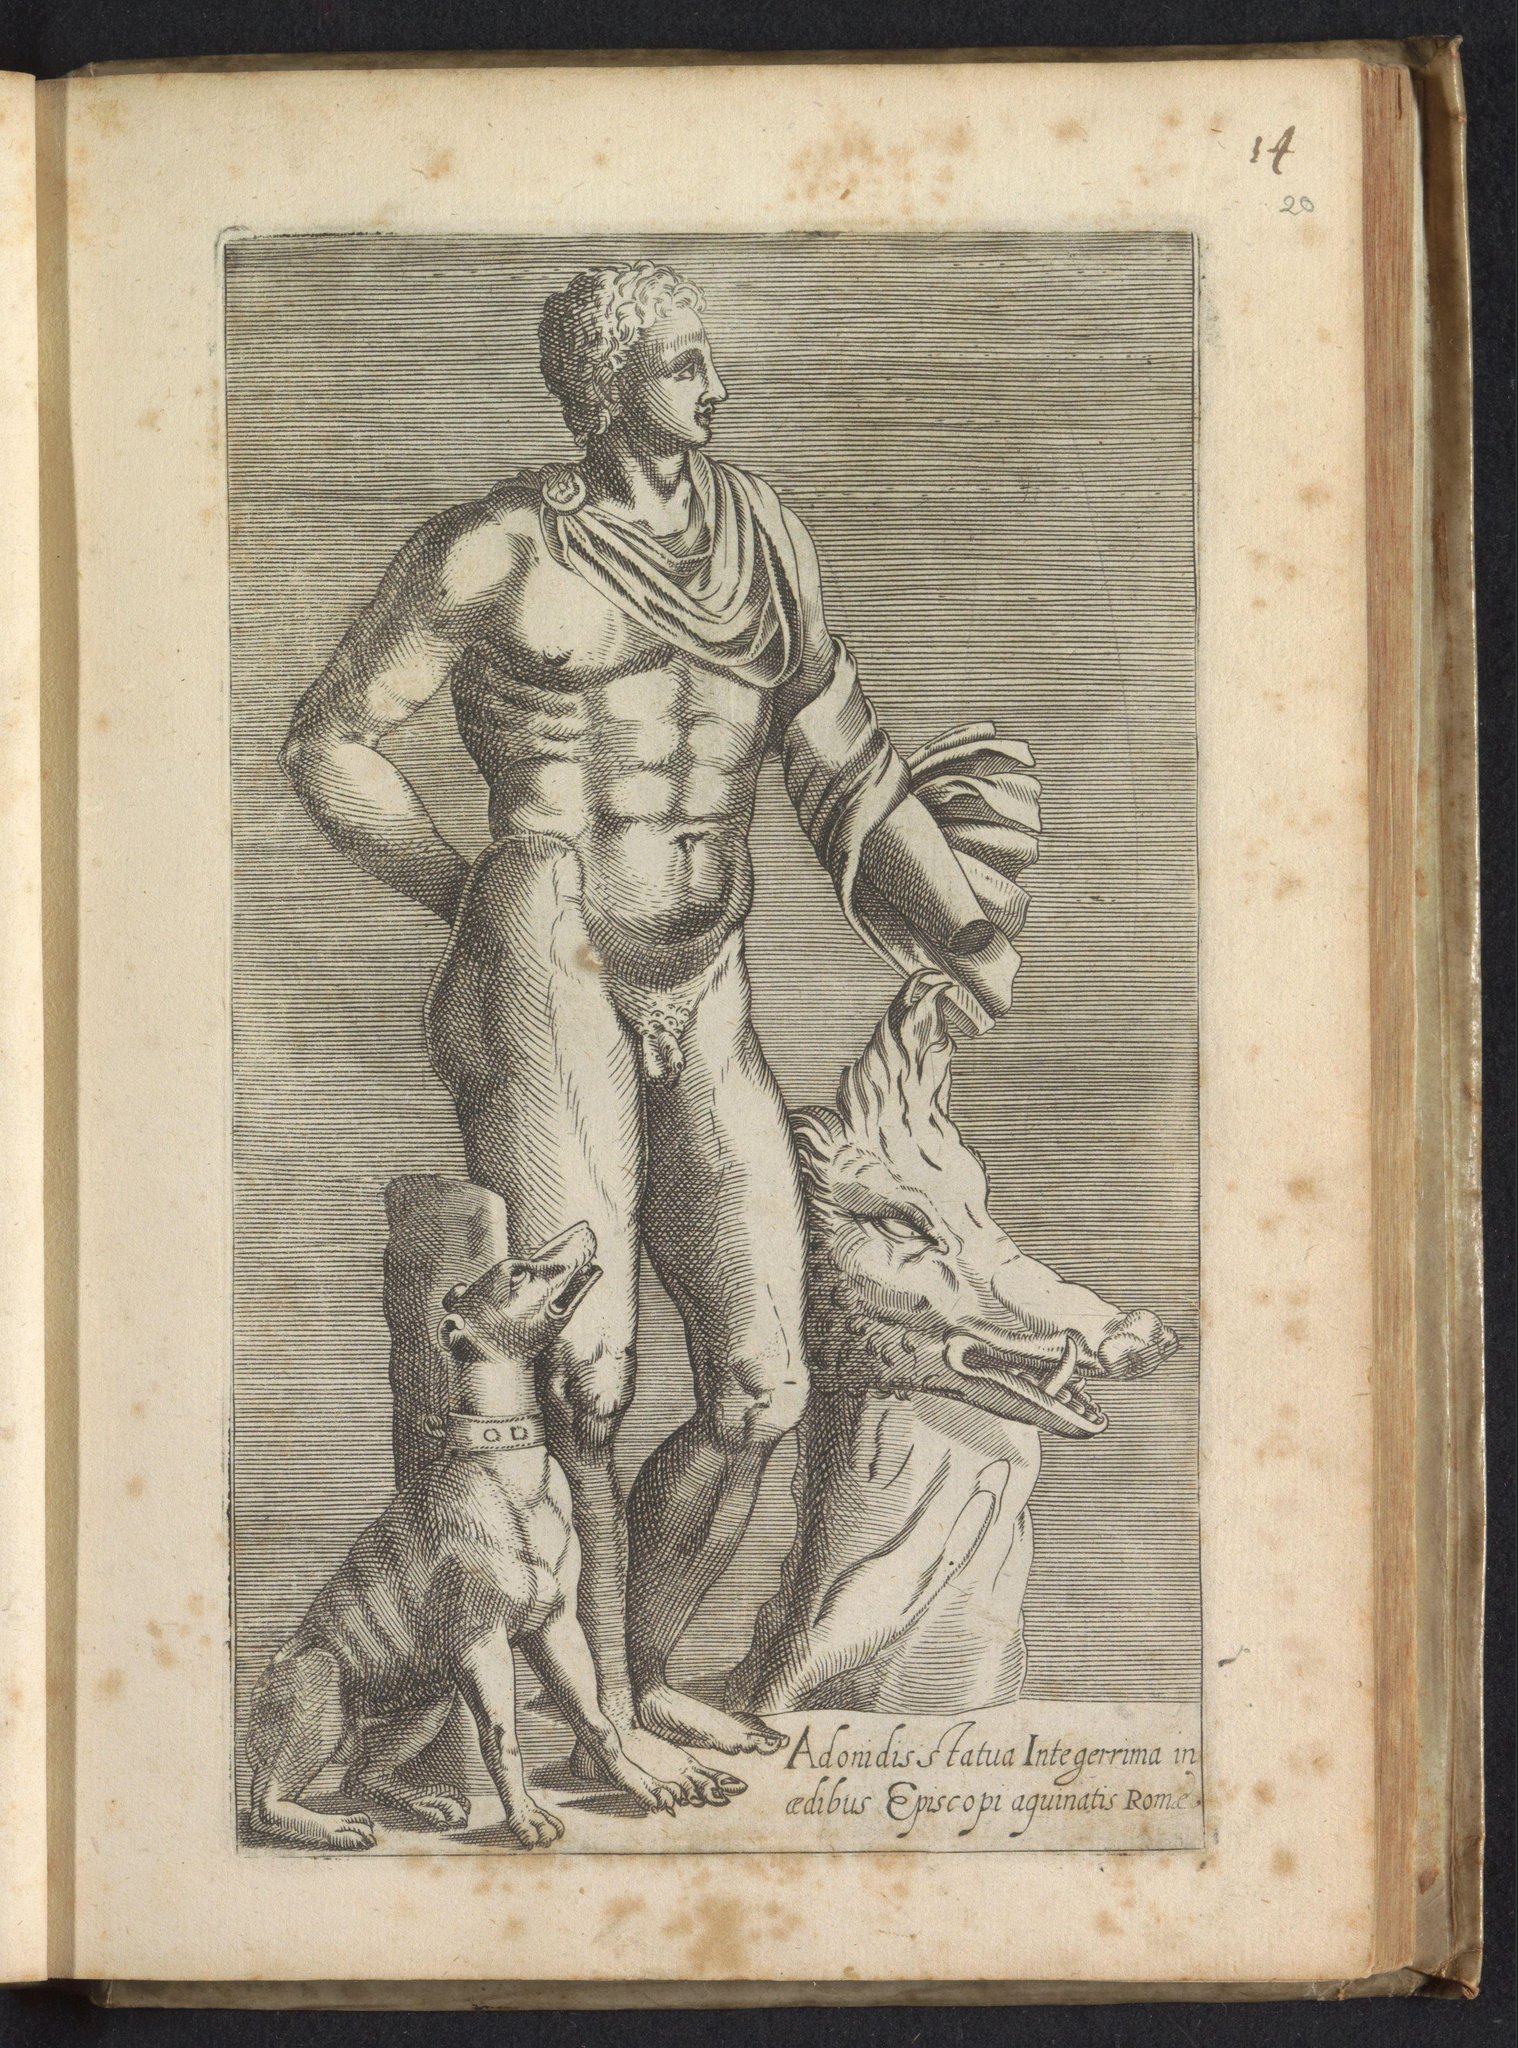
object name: print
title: Antiquarum statuarum urbis Romae quae in publicis locis visuntur icones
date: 1584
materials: paper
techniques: engraving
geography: rome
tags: (story of) adonis, piece of sculpture, reproduction of a piece of sculpture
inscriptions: number: ‘14’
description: Deze prent maakt deel uit van een set van 79 prenten (+ titelprent) met voorstellingen van antieke sculpturen in Rome.